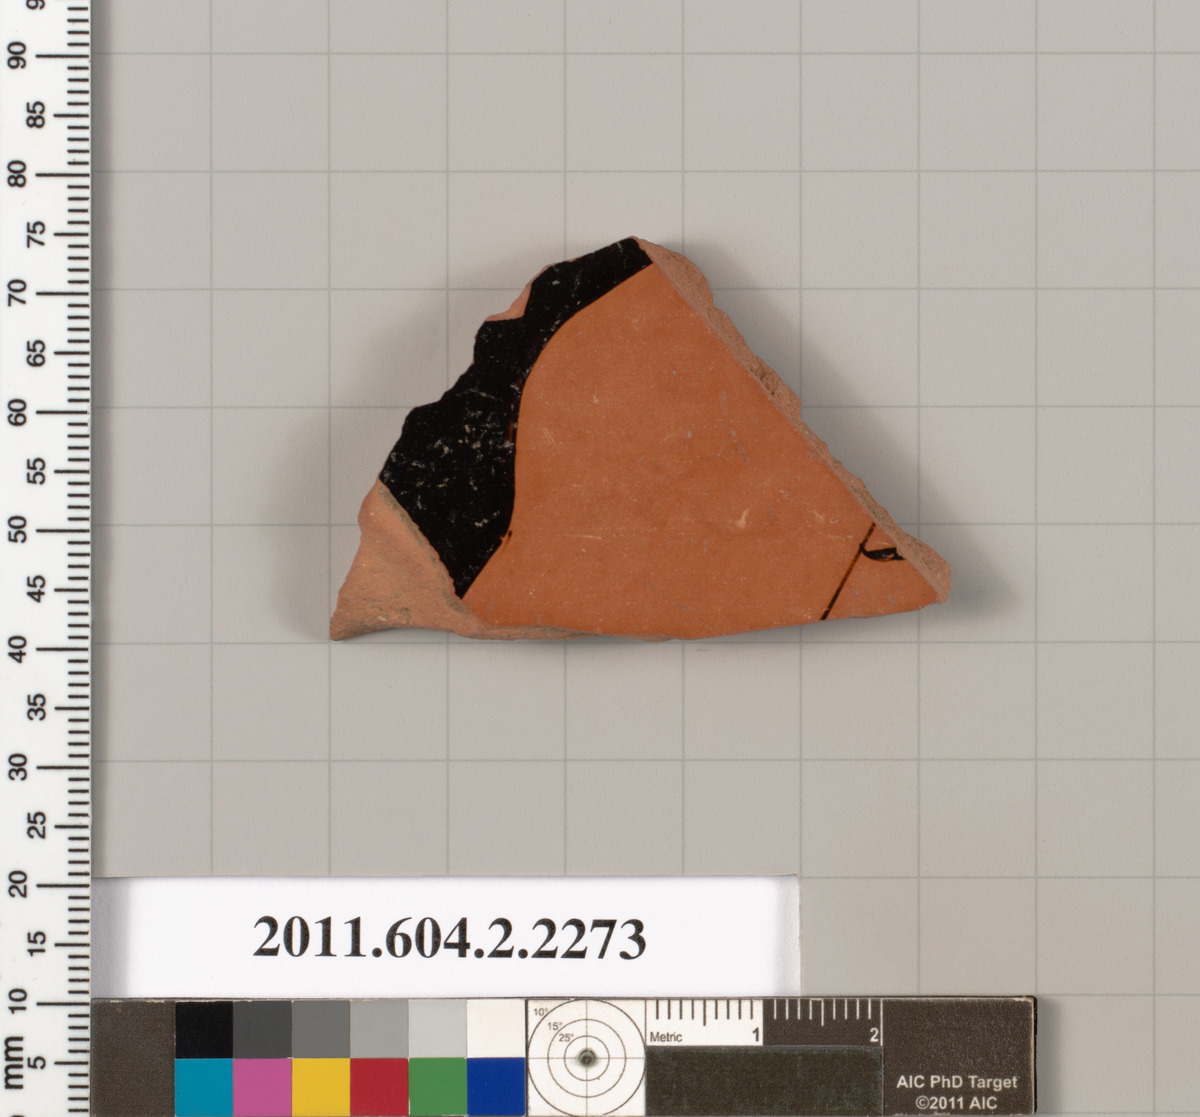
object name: krater fragment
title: Terracotta fragment of a krater (bowl for mixing wine and water)?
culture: greek, attic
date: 475-451 BCE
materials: terracotta